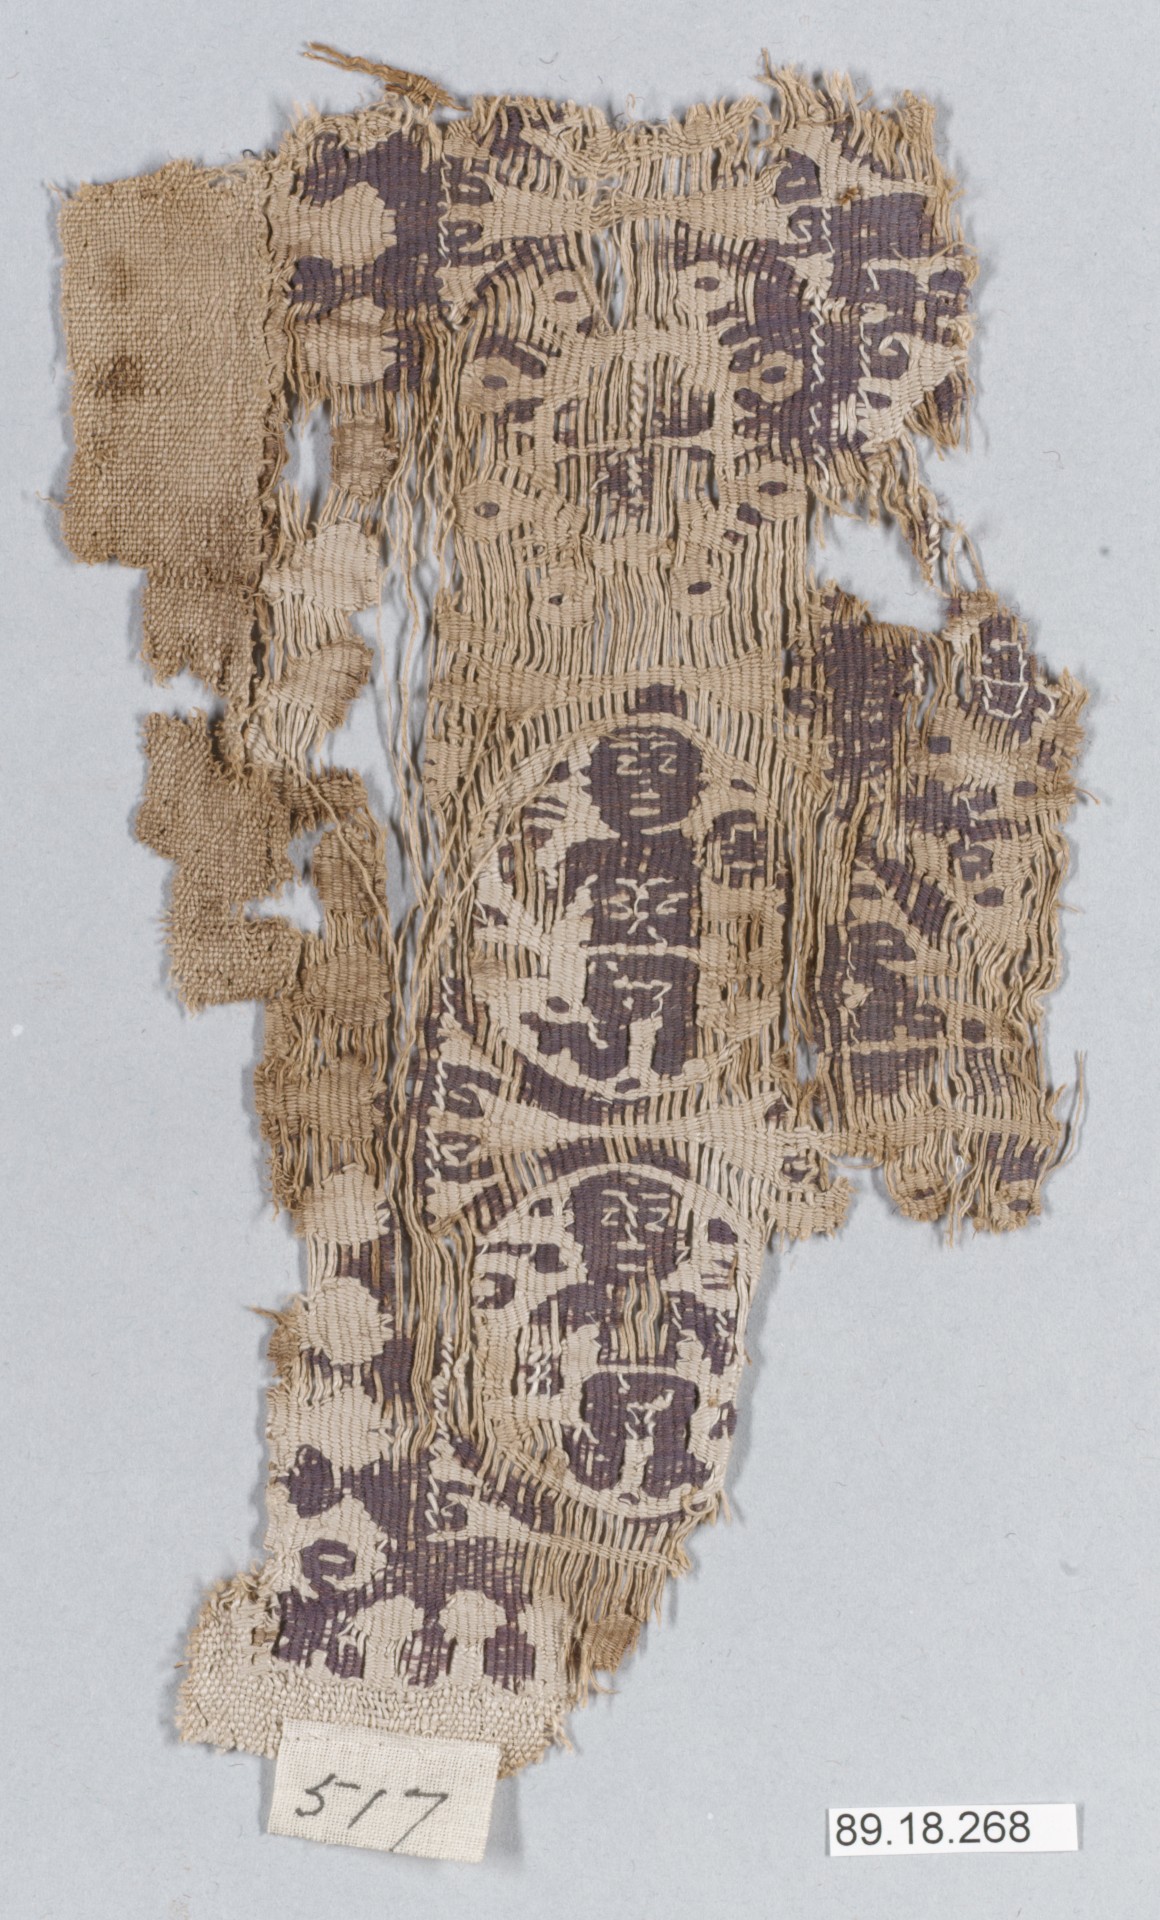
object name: textile fragment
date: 301-400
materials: linen, wool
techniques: weave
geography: egypt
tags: human figures